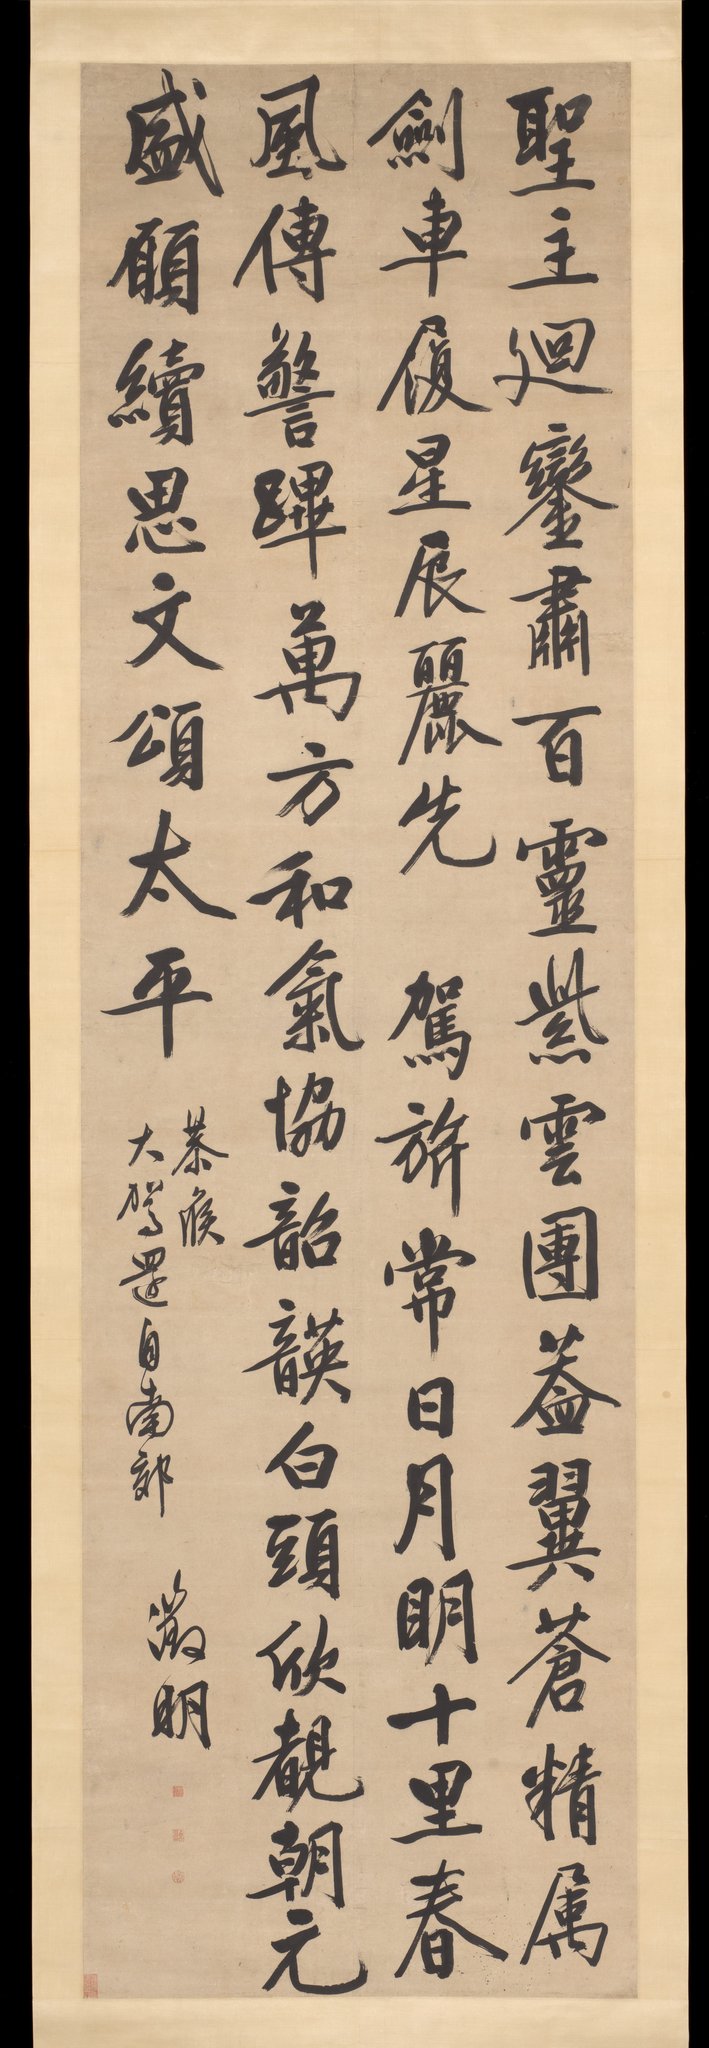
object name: hanging scroll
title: Awaiting the Emperor's Return from the Southern Suburbs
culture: chinese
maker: wen zhengming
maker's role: artist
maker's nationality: chinese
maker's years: 1470-1559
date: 1470-1559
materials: ink, paper